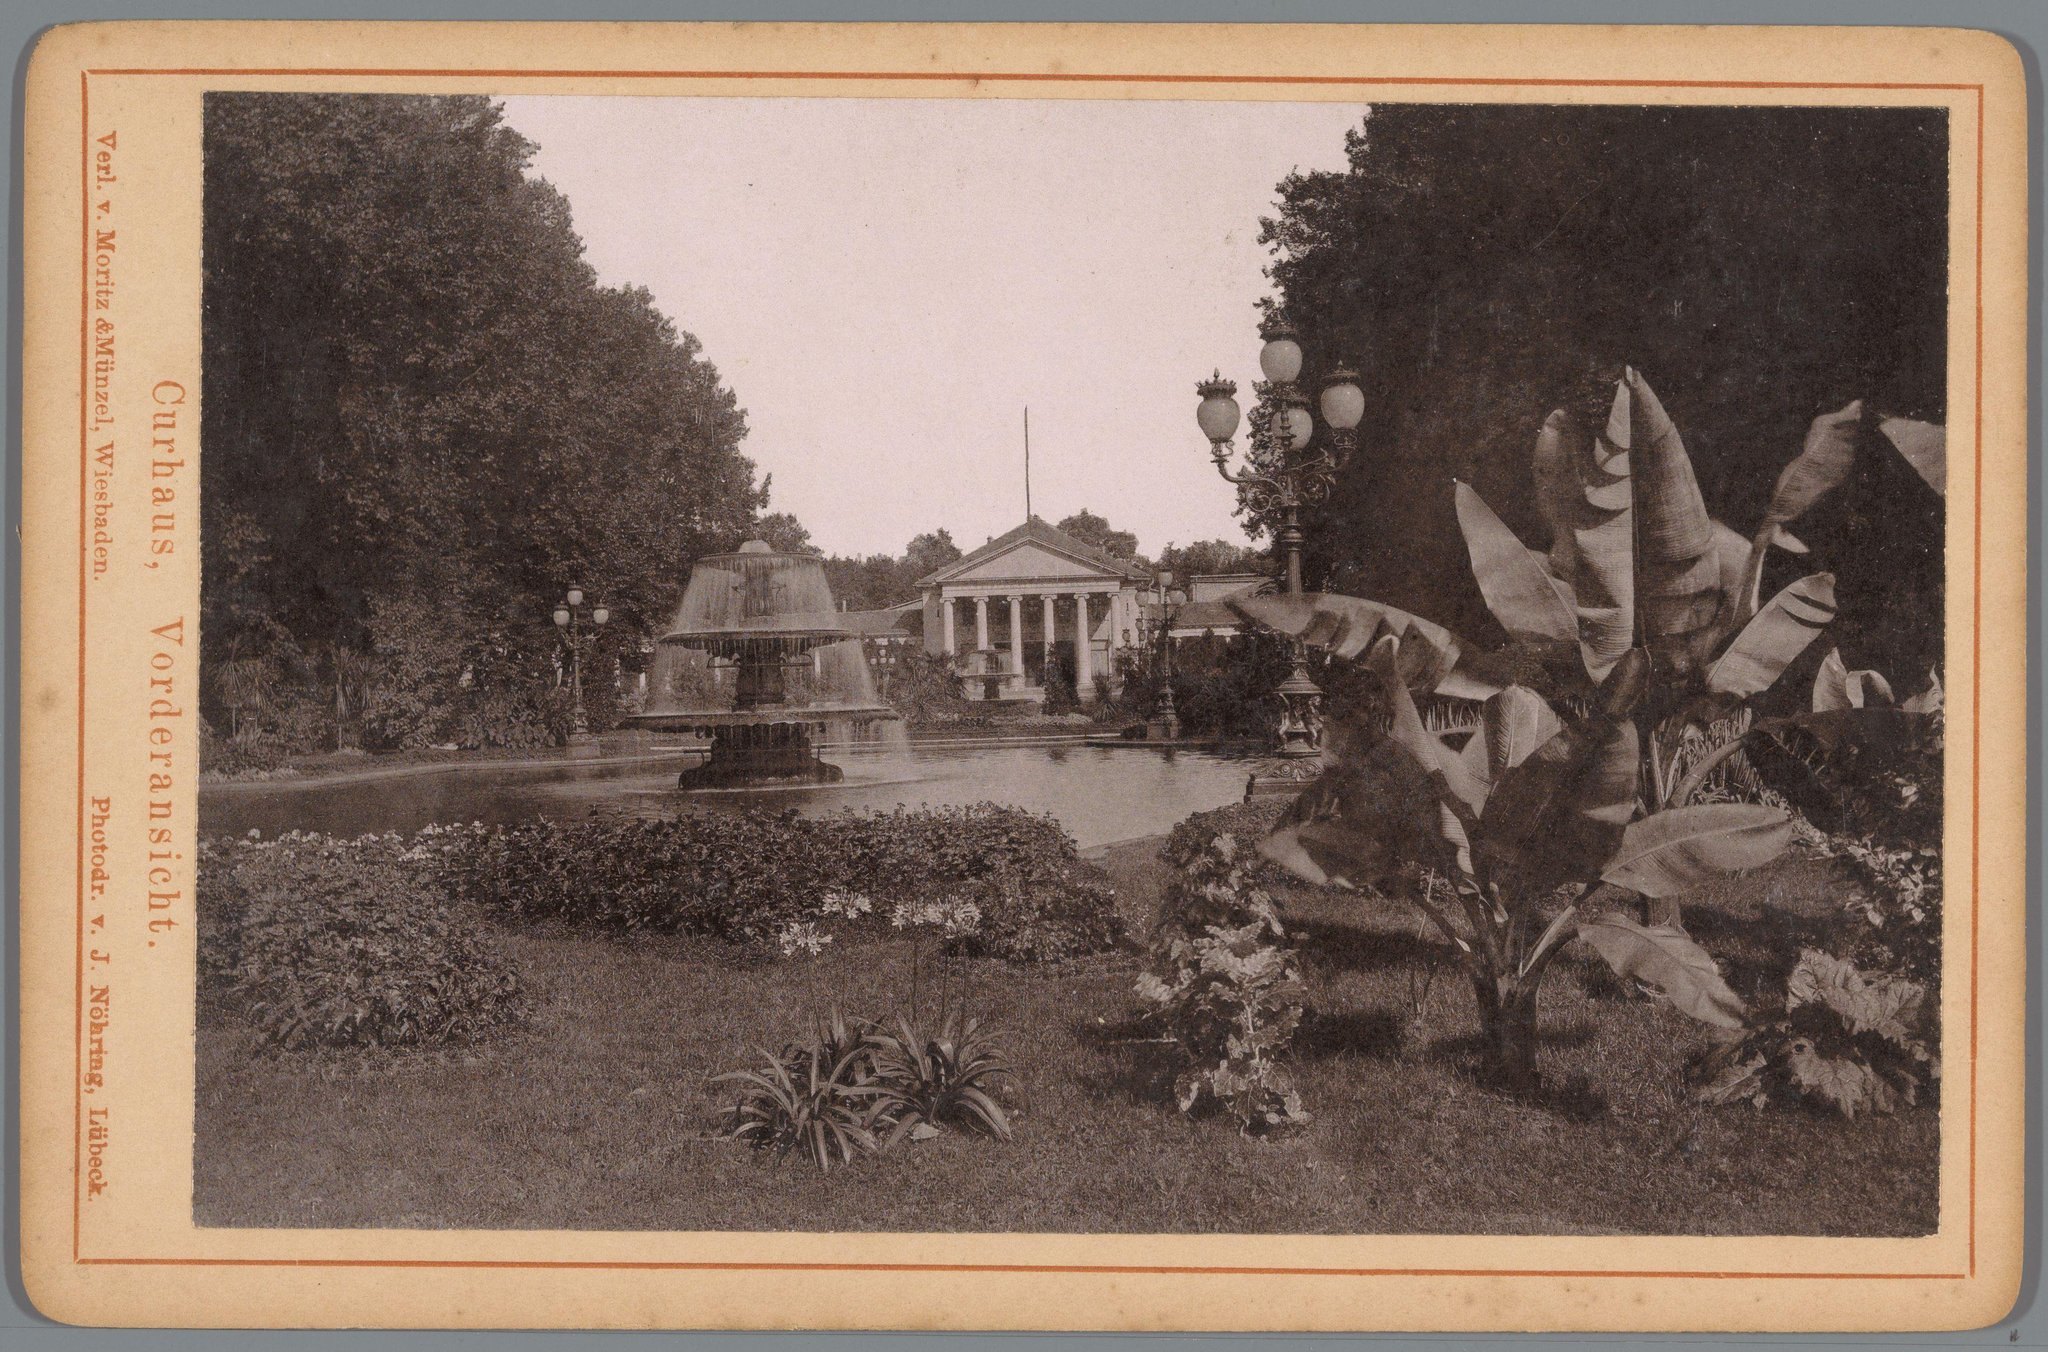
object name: cabinet photograph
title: Curhaus, Vorderansicht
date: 1869-1890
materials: cardboard, paper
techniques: photograph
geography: wiesbaden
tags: watering-place, spa, public gardens, park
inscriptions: name: ‘Vosmaer’